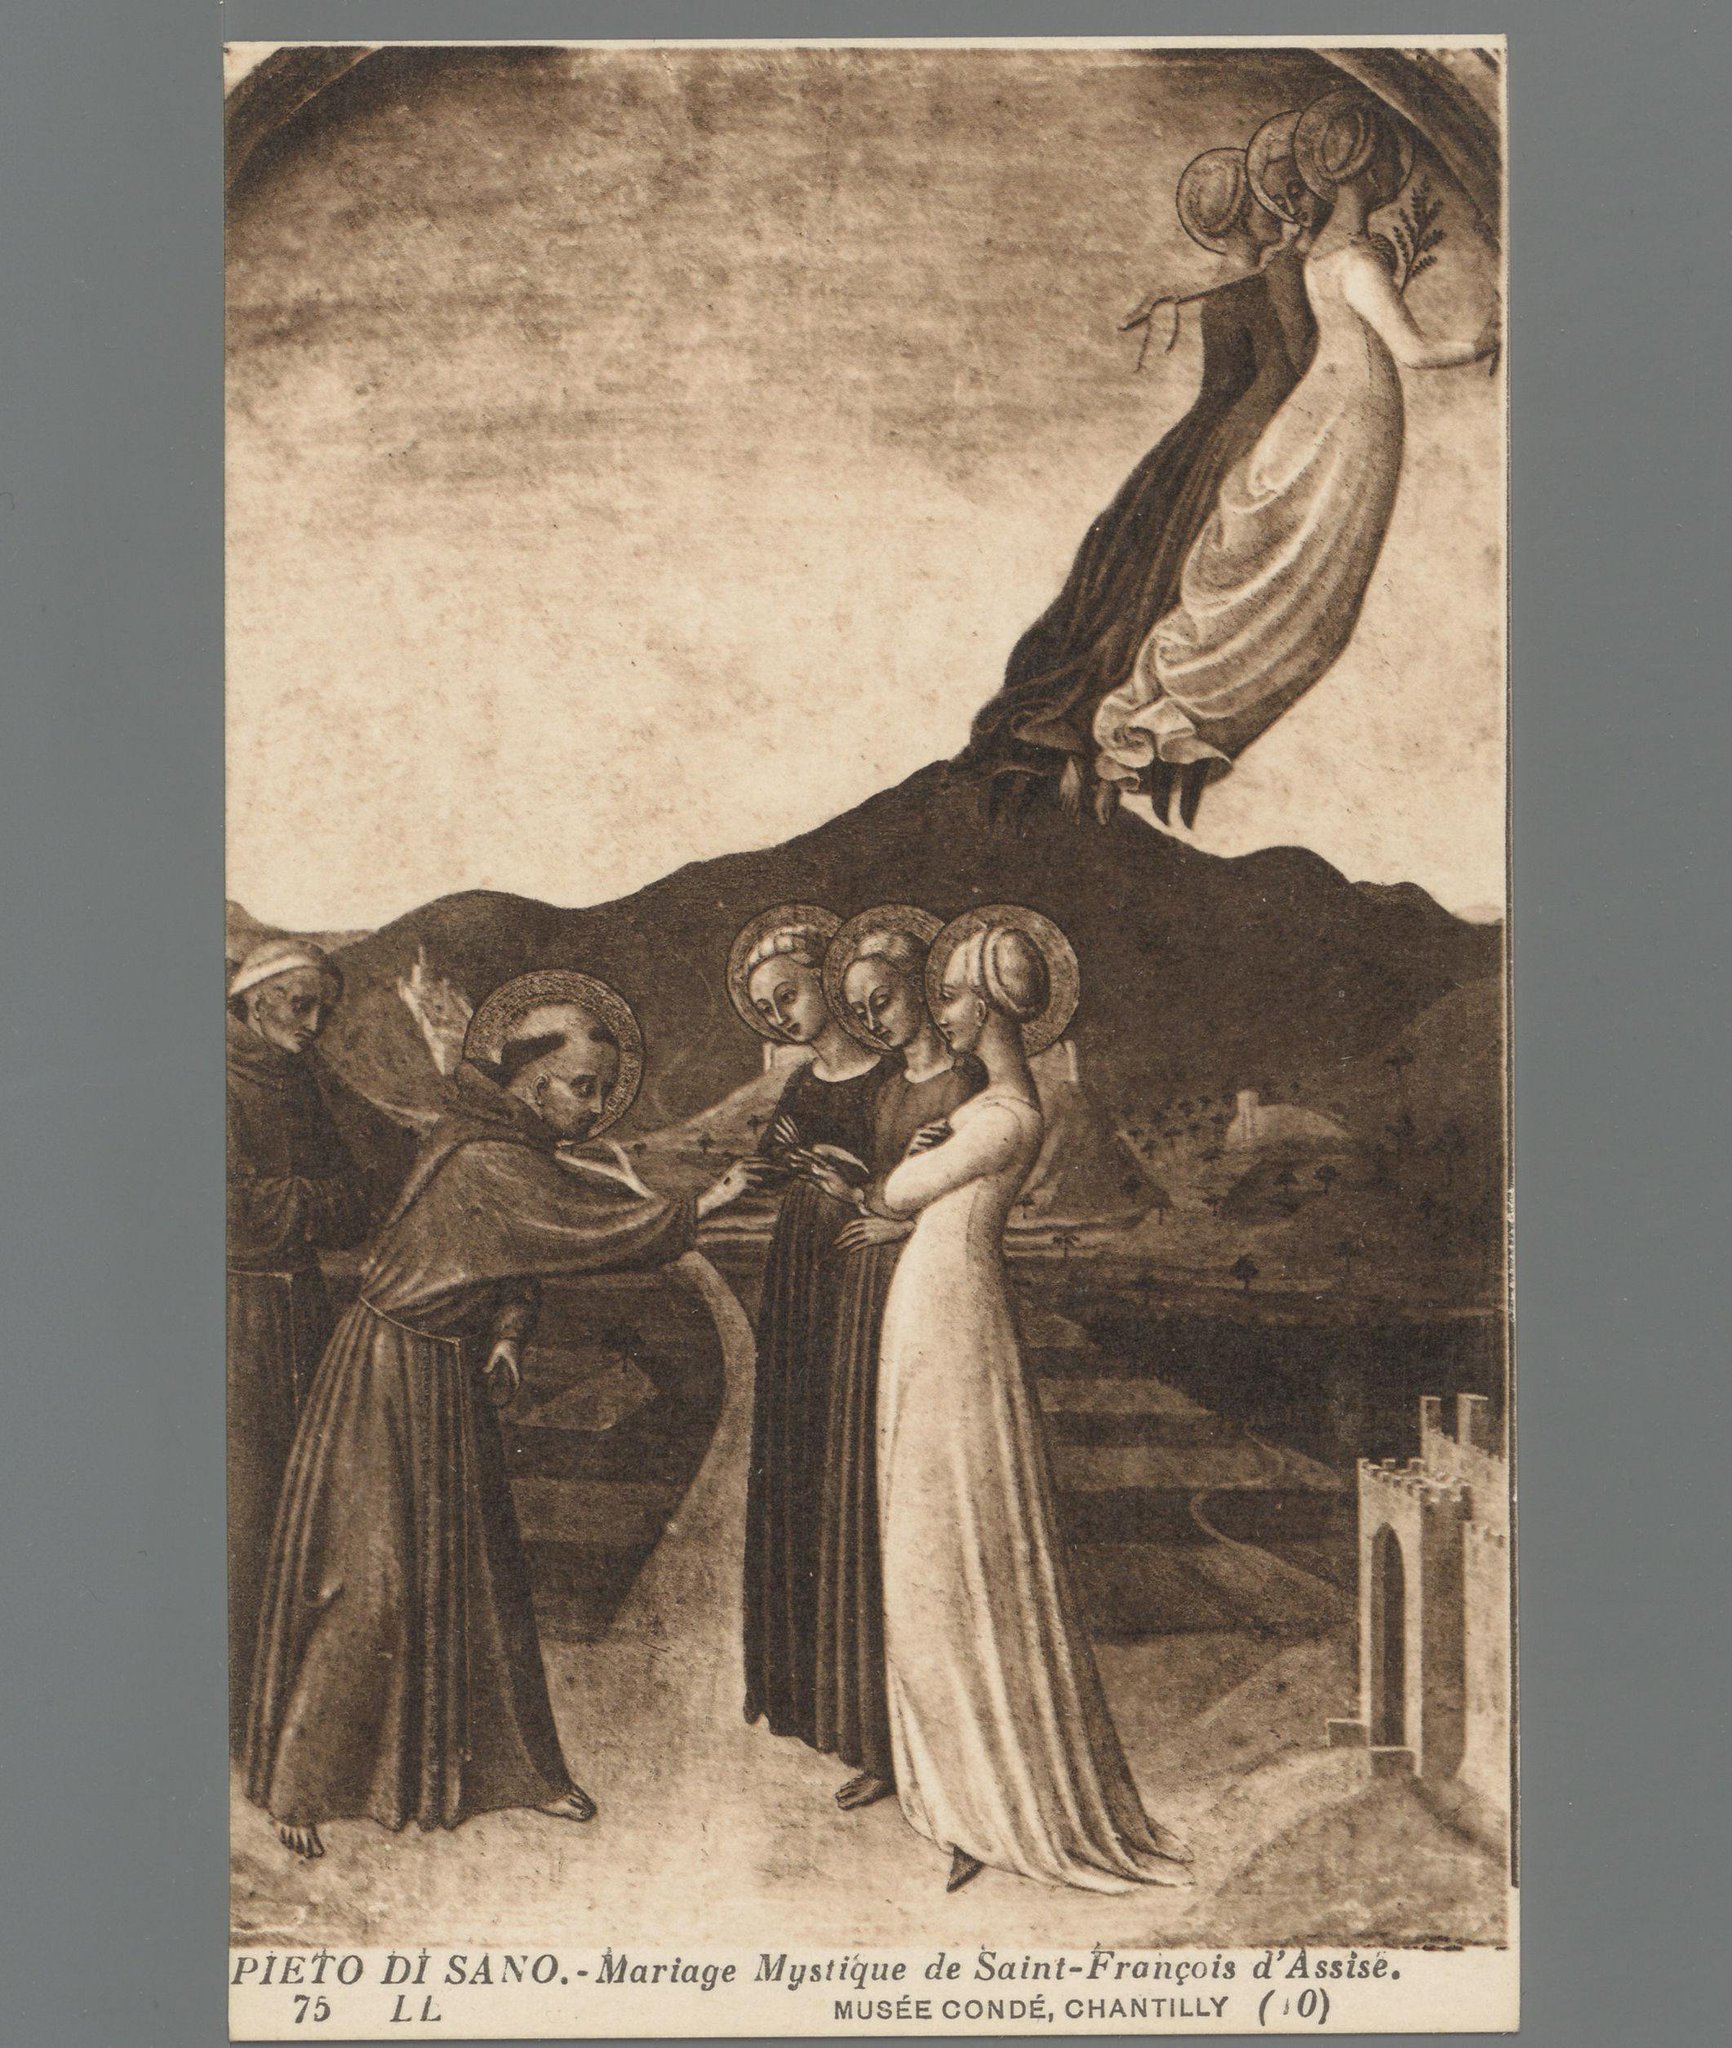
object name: reproduction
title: Pieto di Sano. Mariage Mystique de Saint-François d 'Assise. Musée Condé, Chantilly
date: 1903-1932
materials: cardboard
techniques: photograph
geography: paris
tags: statues, paintings, etc. ~ objects of worship in roman religion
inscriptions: collector's mark: ‘AFE v S’